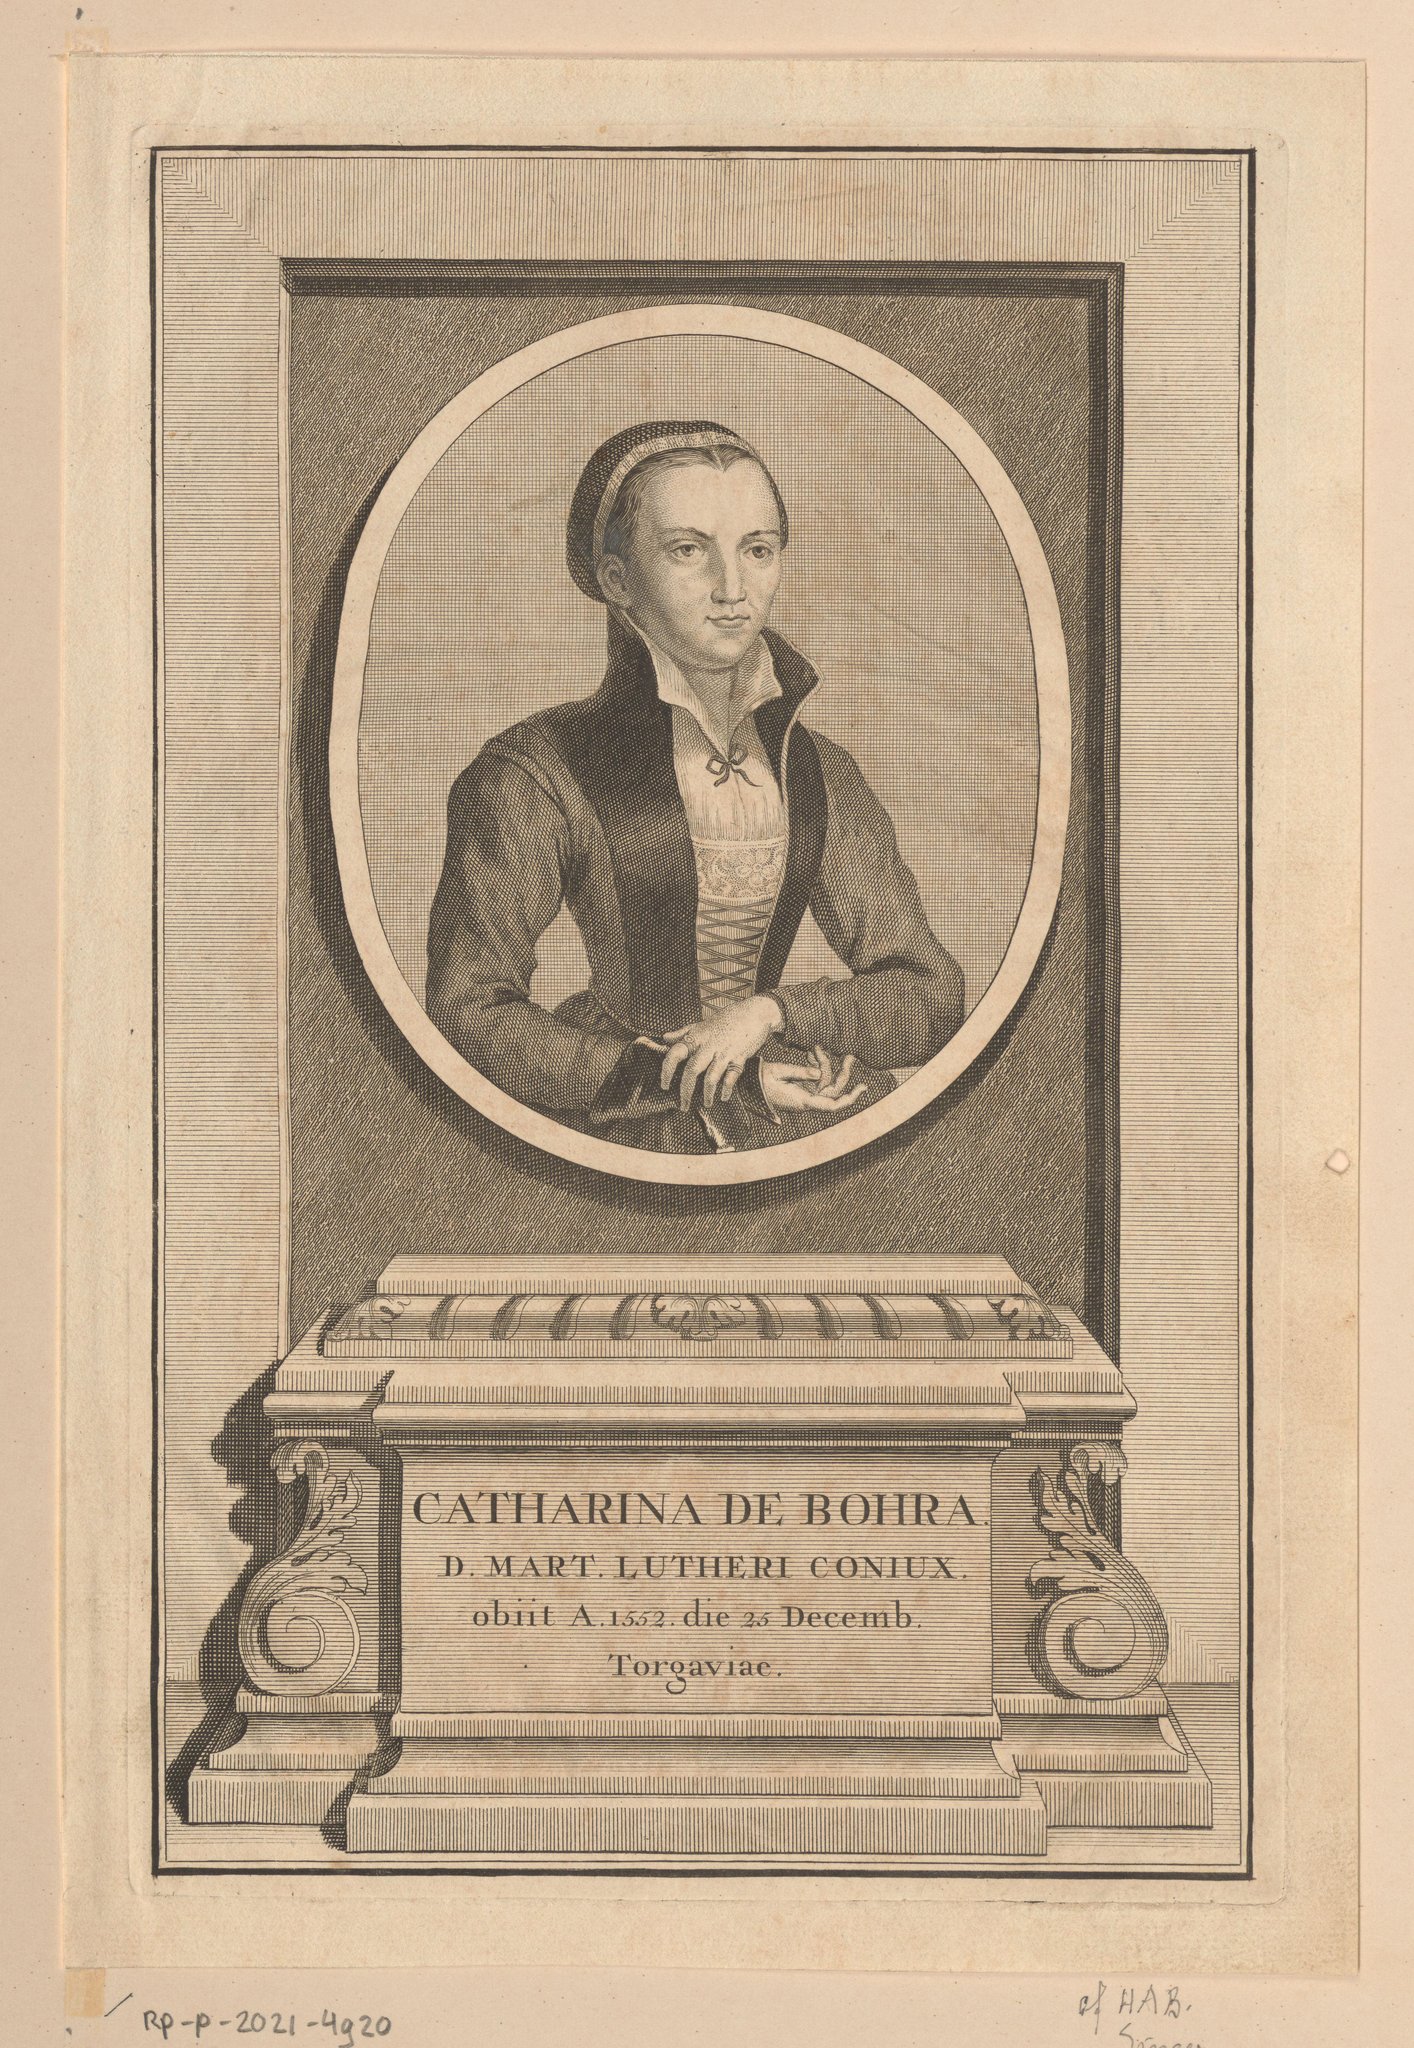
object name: print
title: Portret van Katharina von Bora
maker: Anonymous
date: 1728-1734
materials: paper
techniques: etching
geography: northern netherlands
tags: historical persons - bb - woman, ornament ~ medallion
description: Prent waarschijnlijk uit: Seckendorf, Veit-Ludwig von. Uitvoerige en onpartydige historie der reformatie (...). Delft: Reinier Boitet, 1728. Ook gebruikt in: Paauw, Andries. 't Omstandige leven van den groten kerken leeraar en reformateur, docter Martinus Lutherus (...). Amsterdam: Samuel Schoonwald, 1731. En in: Juncker, Christian. De goude en zilvere eergedagtenis van Dr. M. Luther (...). Den Haag: s.n., 1734.